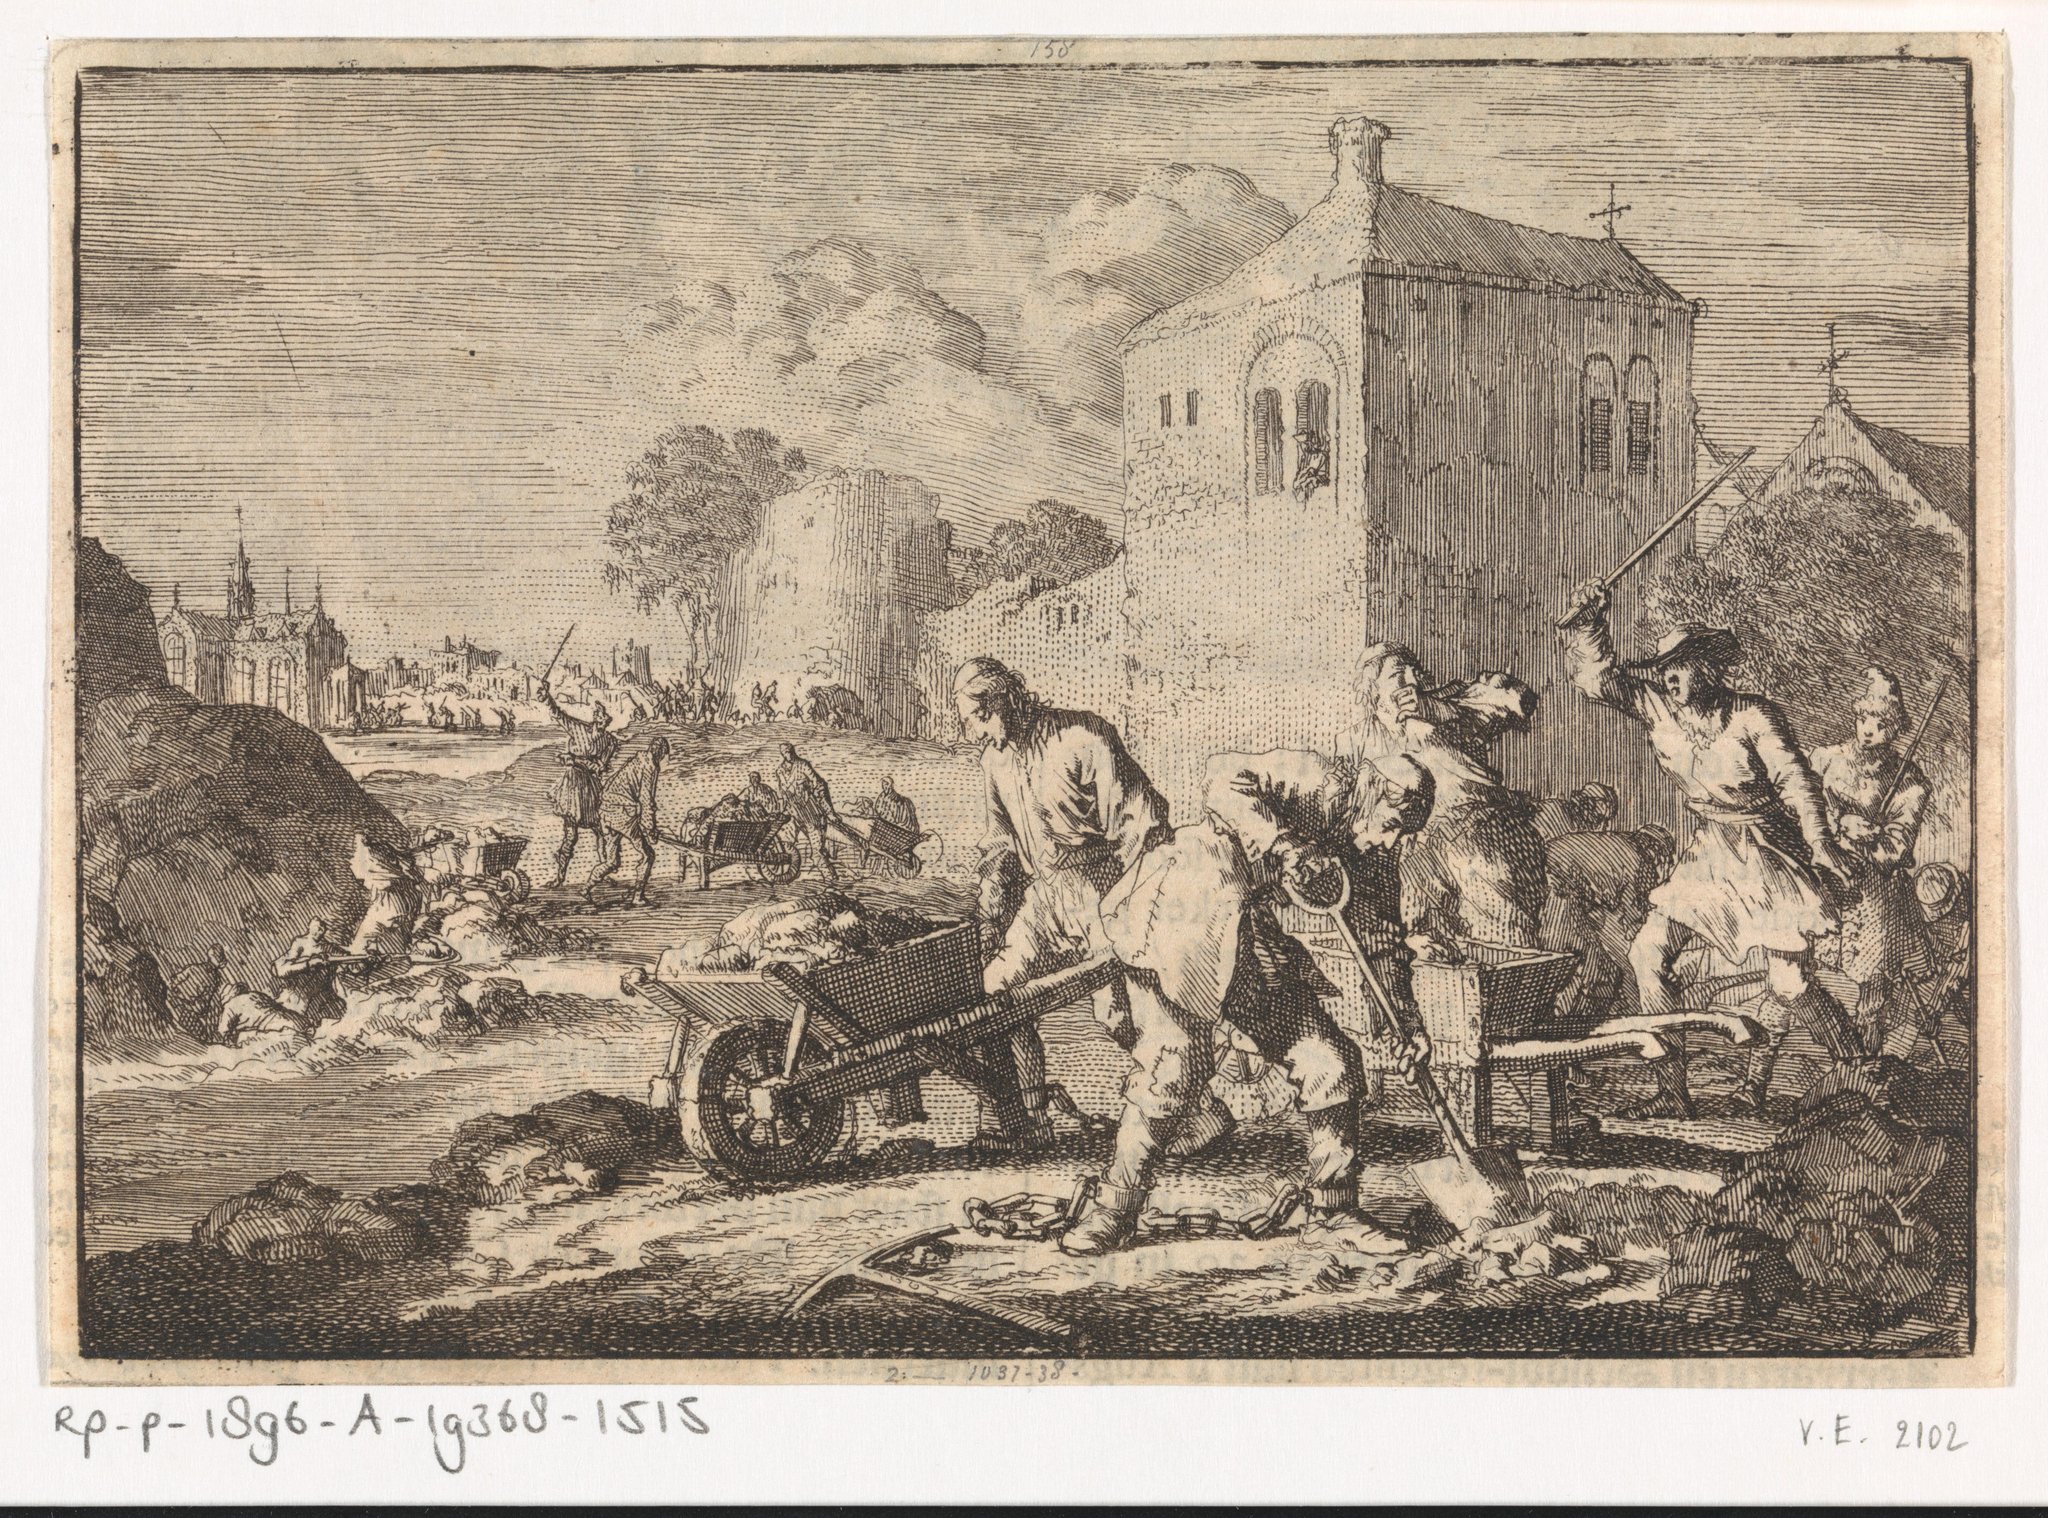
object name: book illustration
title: Hervormde predikanten in Hongarije veroordeeld tot zware arbeid, 1674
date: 1698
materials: paper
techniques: etching, letterpress printing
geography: leiden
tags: workhouse, penal camp, penitentiary, chain gang, persecution of believers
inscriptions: collector's mark: Lugt 2228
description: Illustratie uit: Gottfried, Johann Ludwig. Historische kronyck; vervattende een (...) beschrijvingh der aldergedenckwaerdigste geschiedenissen des weerelds, van den aenvangh der scheppingh tot (...) 1576 (2 delen). Leiden: Pieter van der Aa, 1698, dl. II, p. 1037.